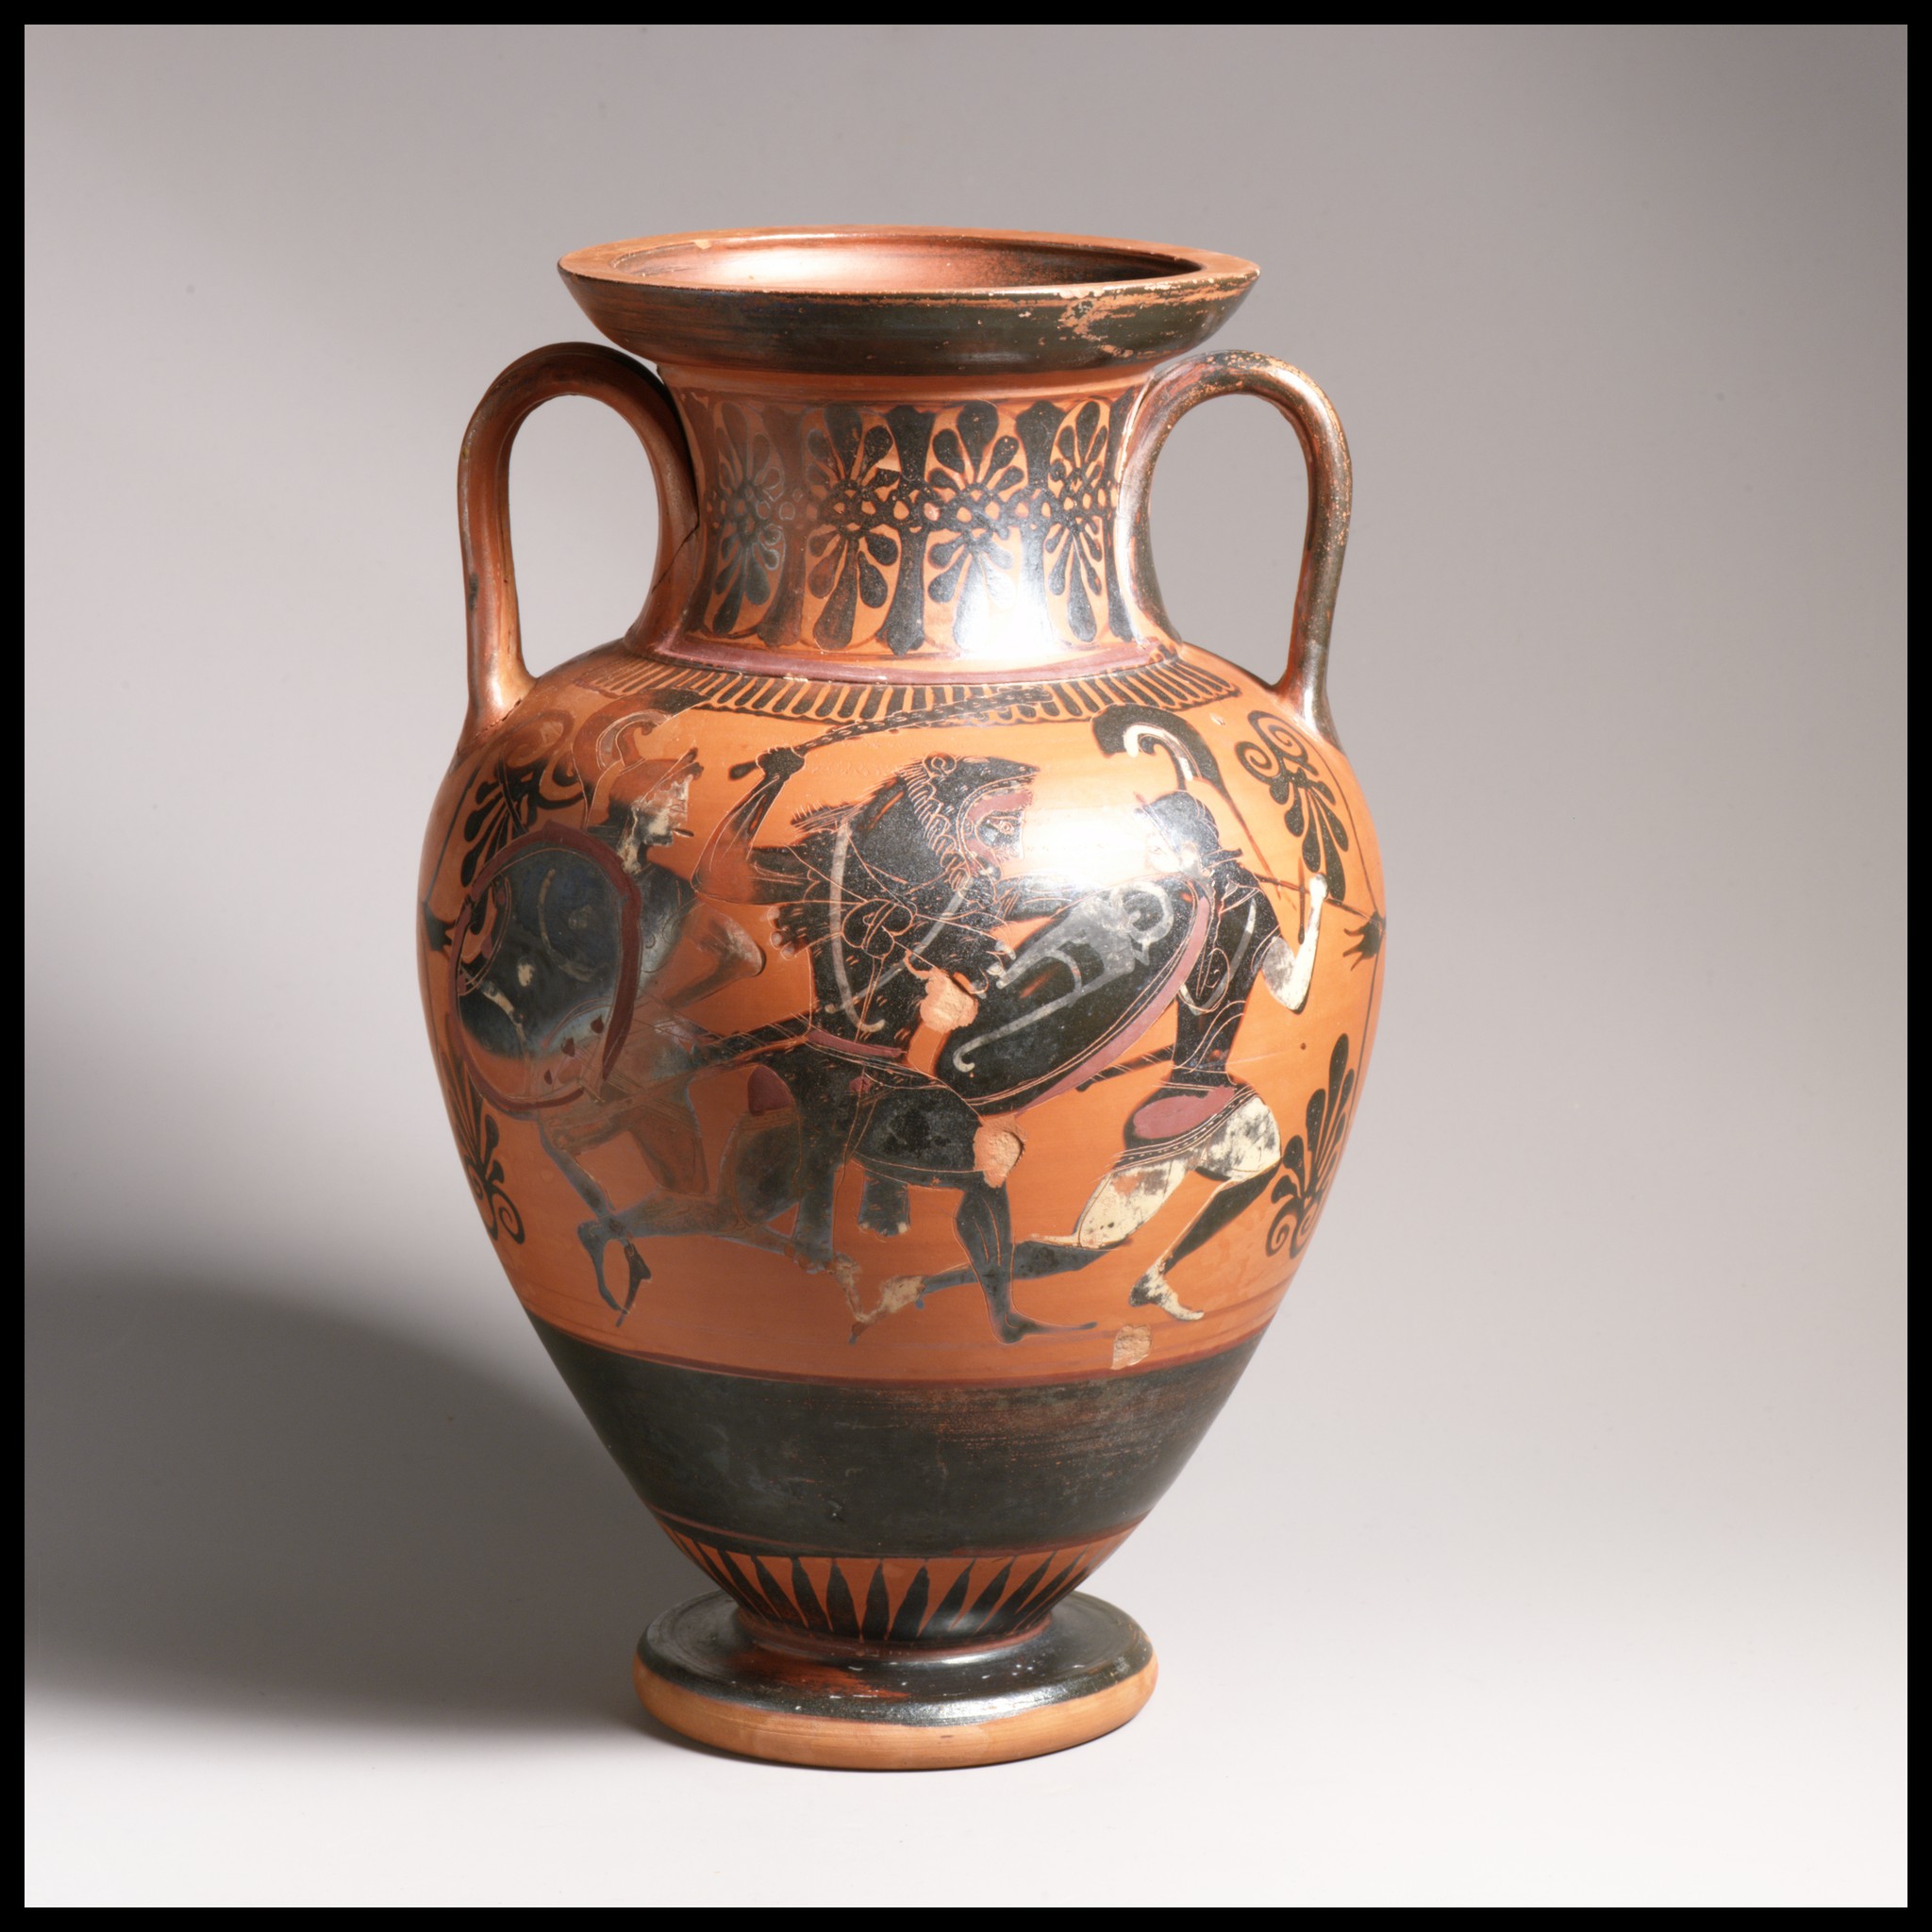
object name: neck amphora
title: Neck-amphora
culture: greek, attic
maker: painter of toronto 313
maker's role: artist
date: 525-501 BCE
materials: terracotta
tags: battles,weapons,amazons,herakles